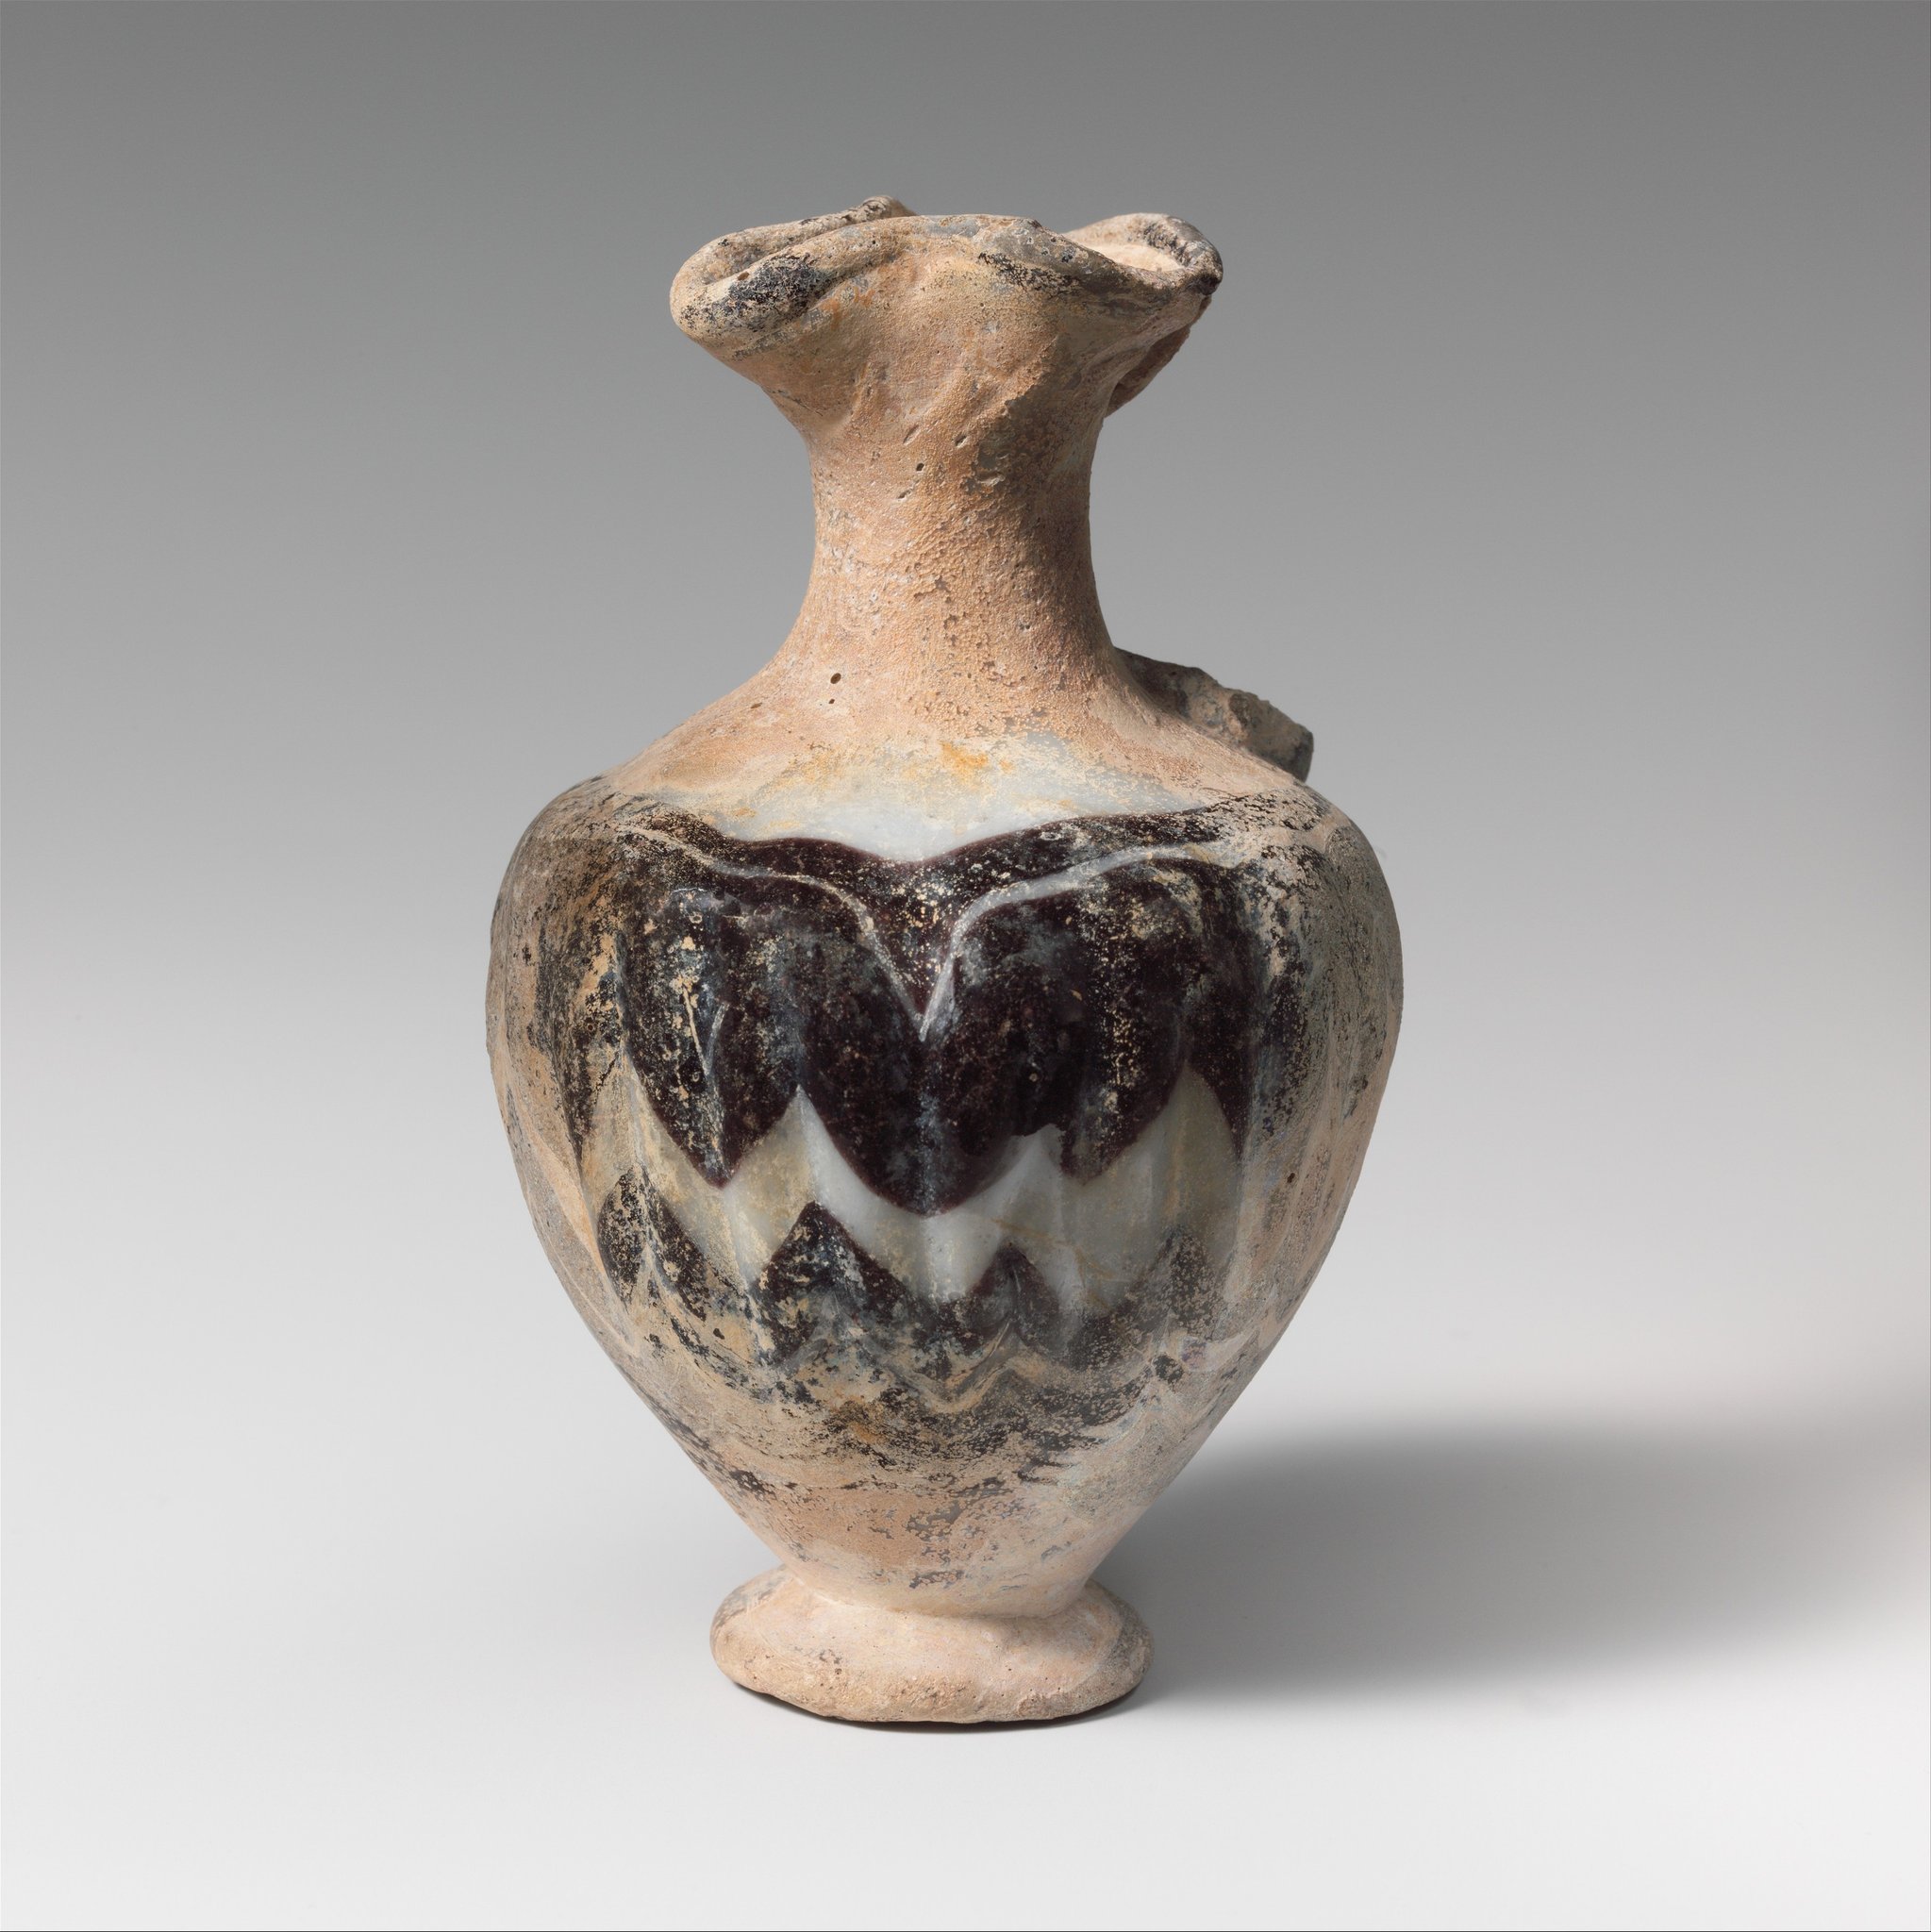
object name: oinochoe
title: Glass oinochoe (perfume jug)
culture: greek, eastern mediterranean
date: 534-401 BCE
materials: glass